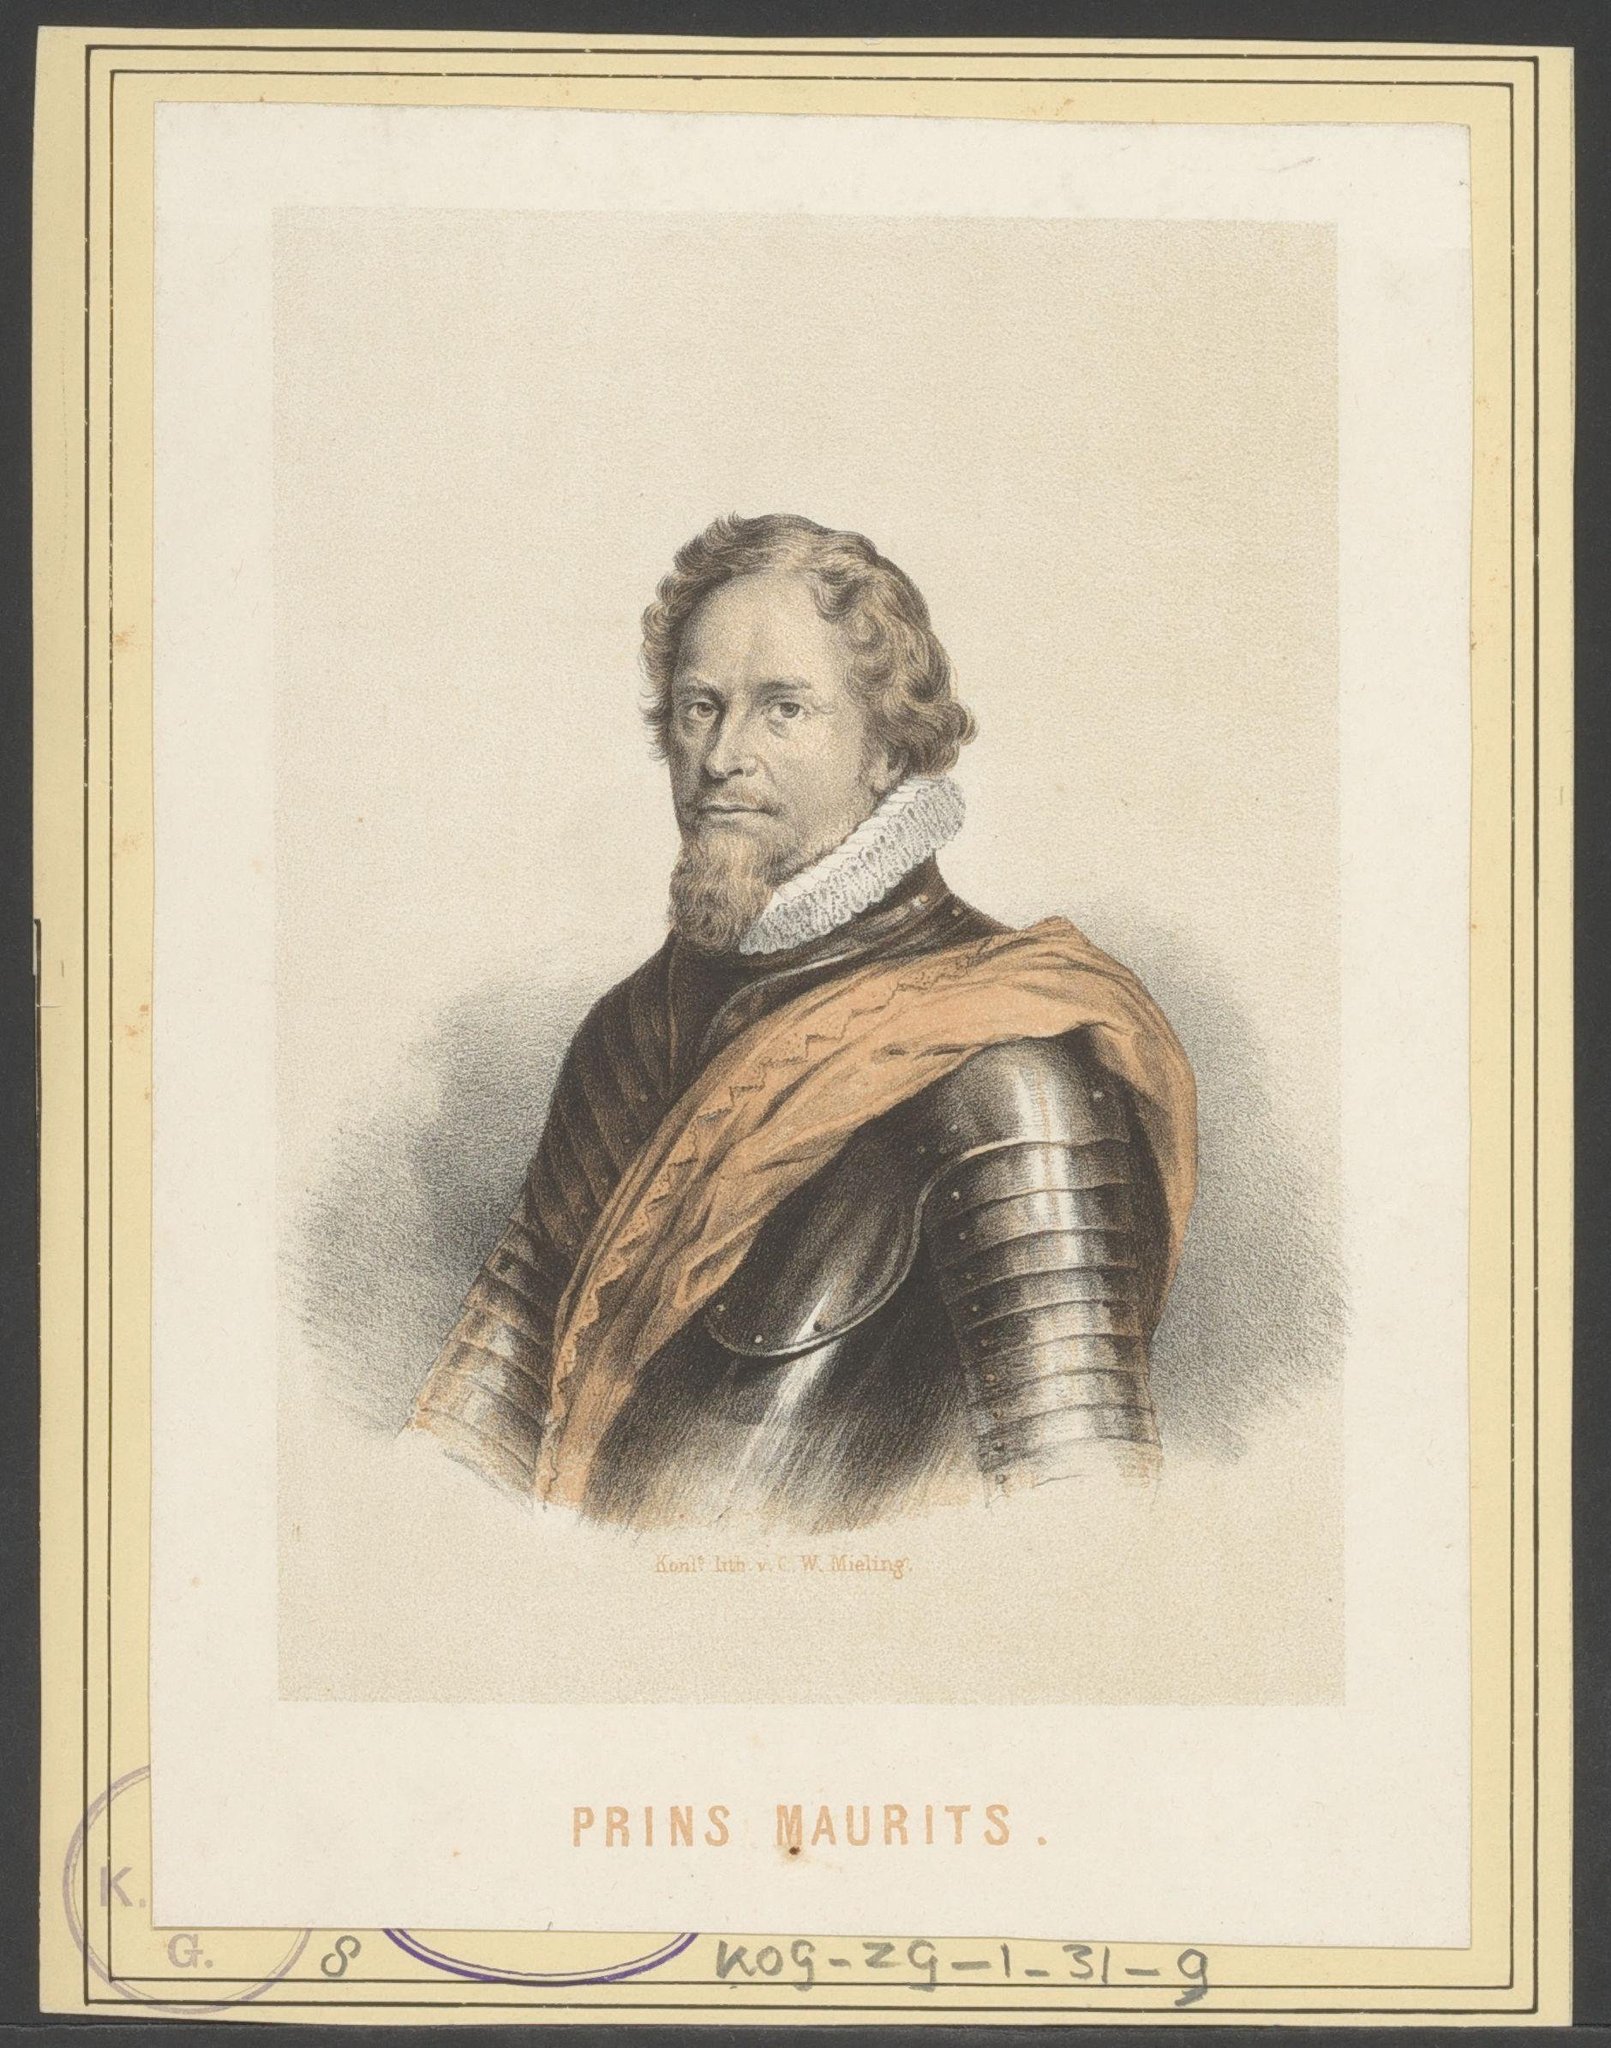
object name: print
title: Prins Maurits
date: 1839-1865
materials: paper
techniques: tone lithography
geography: the hague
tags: the hague, maurice (prince of orange), harness, historical persons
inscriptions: collector's mark: Lugt 1641, stamp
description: Onderwerpsrubrieken binnen de Atlas Zeden en Gewoonten: Portretten, Portretten van Vorsten uit het huis van Oranje, Regeerende Vorsten, Stadhouders van Holland, Zeeland en West-Friesland.